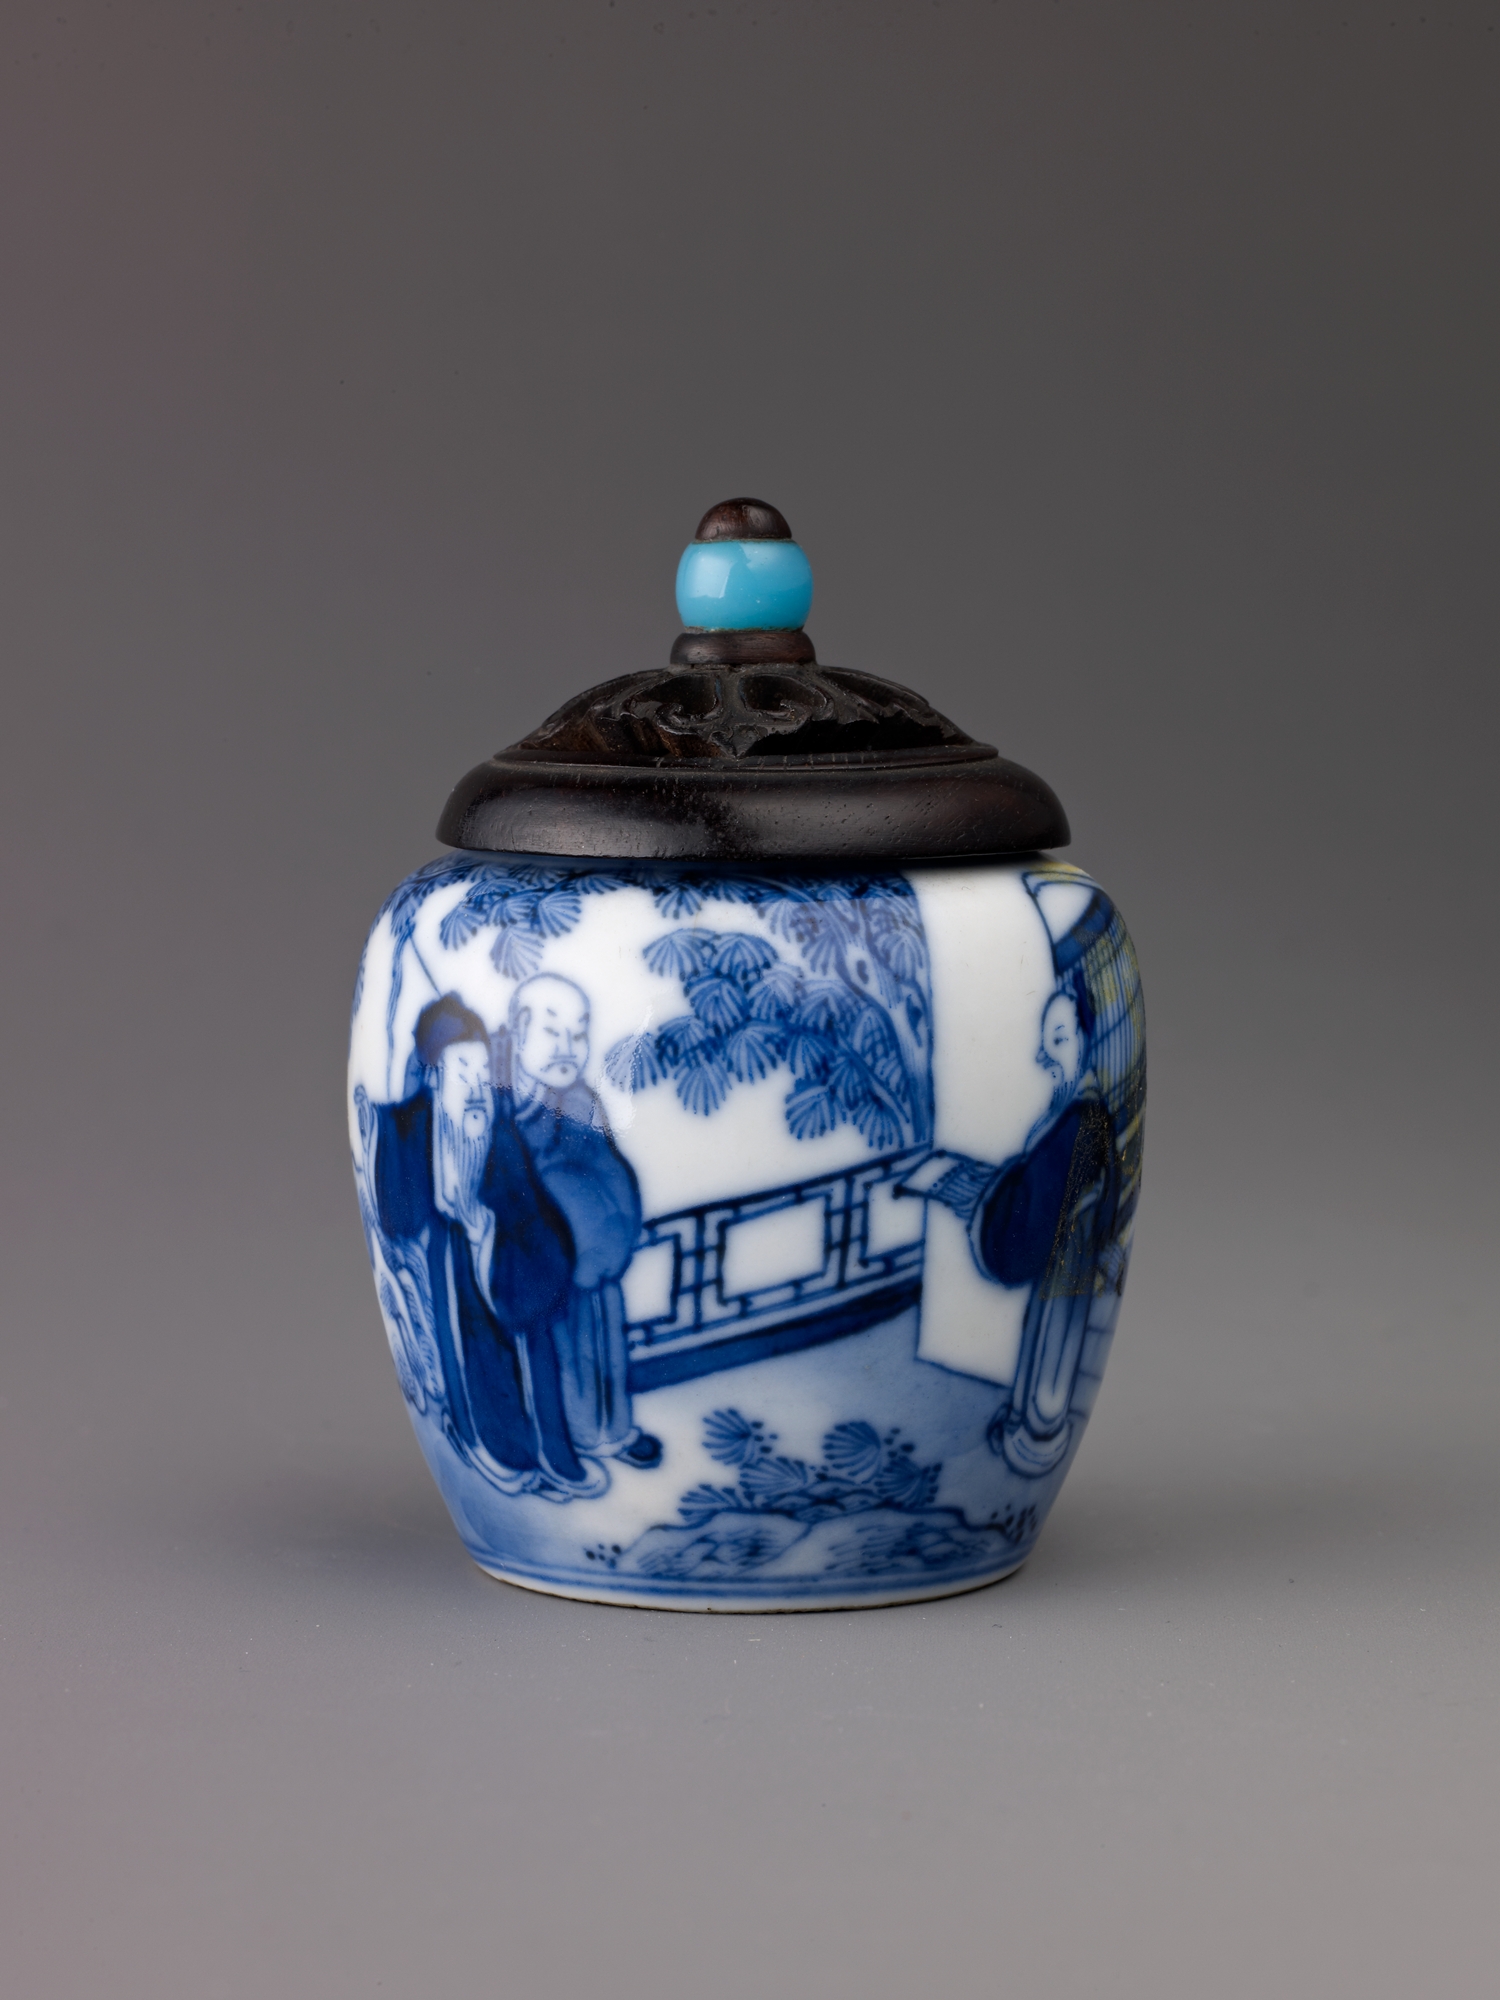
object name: cup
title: Bird-cage cup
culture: chinese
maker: chinese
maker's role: artist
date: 1662-1722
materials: porcelain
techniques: painting, underglaze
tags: men